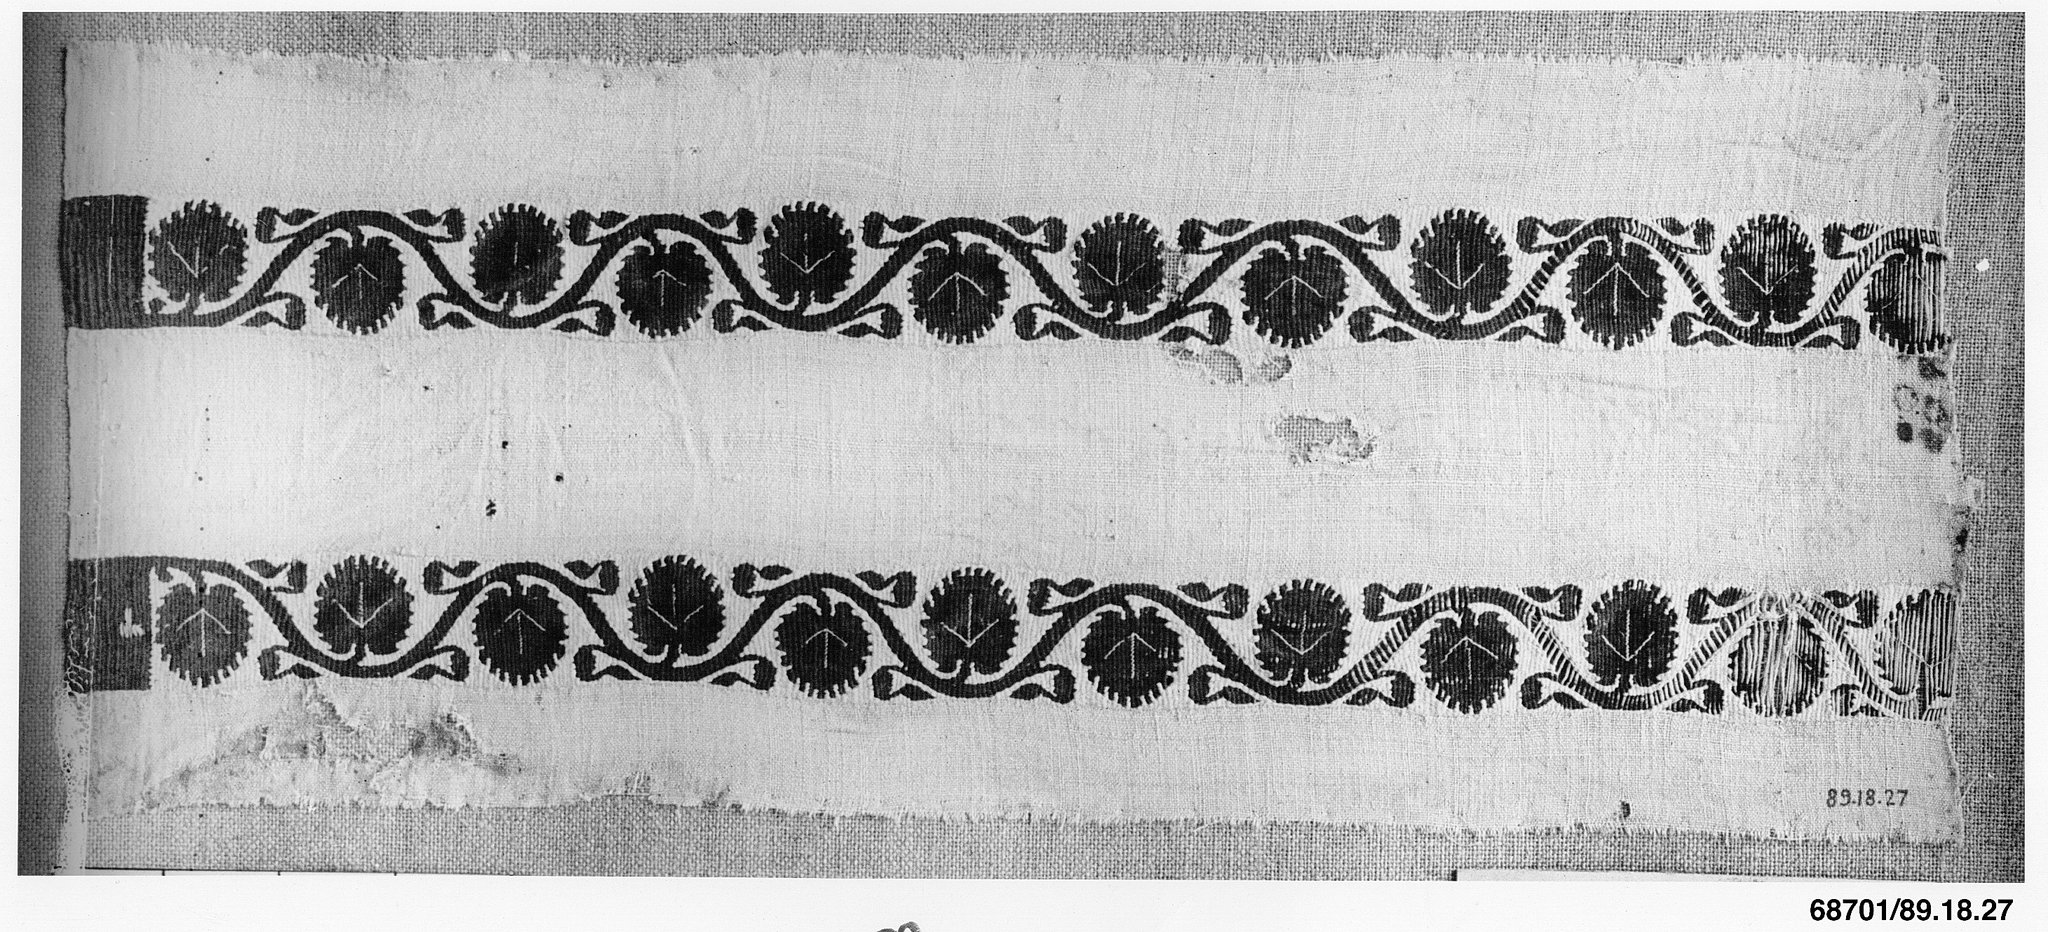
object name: textile fragment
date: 201-400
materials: linen, wool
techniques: weave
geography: egypt